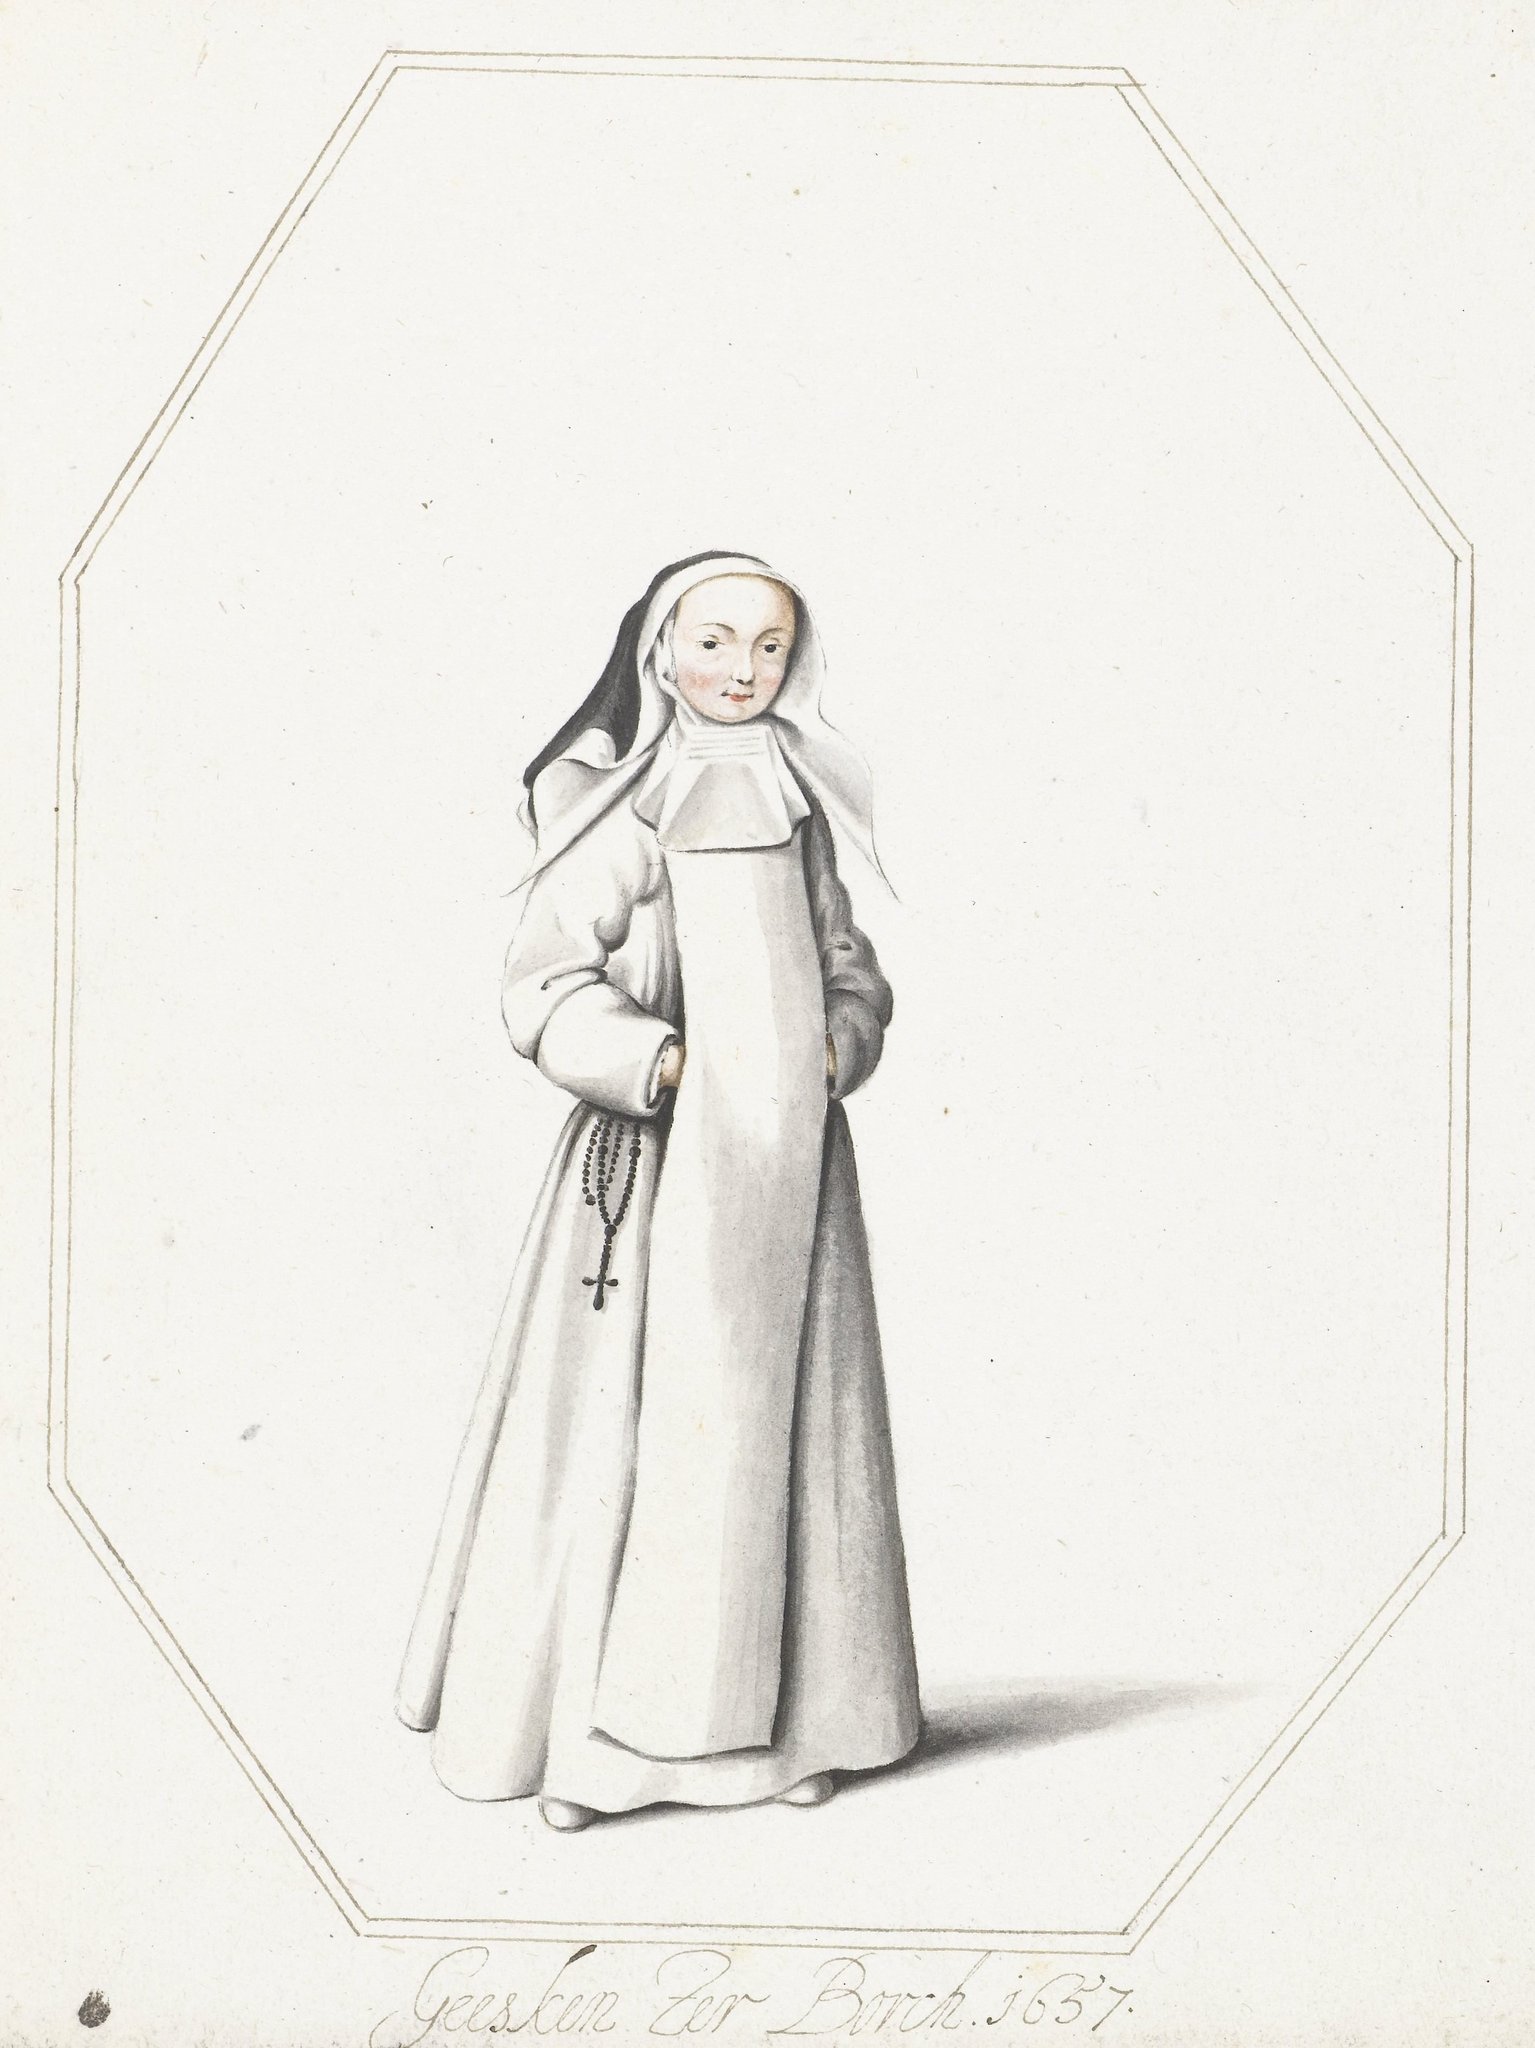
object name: drawing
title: Staande non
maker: gesina ter borch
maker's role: draughtsman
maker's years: 1633-1690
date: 1657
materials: ink, paper, watercolor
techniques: brush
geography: zwolle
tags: nun(s)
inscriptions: signature and date: ‘Geesken ter Borch. 1657.’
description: Een van twee tekeningen gemaakt op hetzelfde blad.